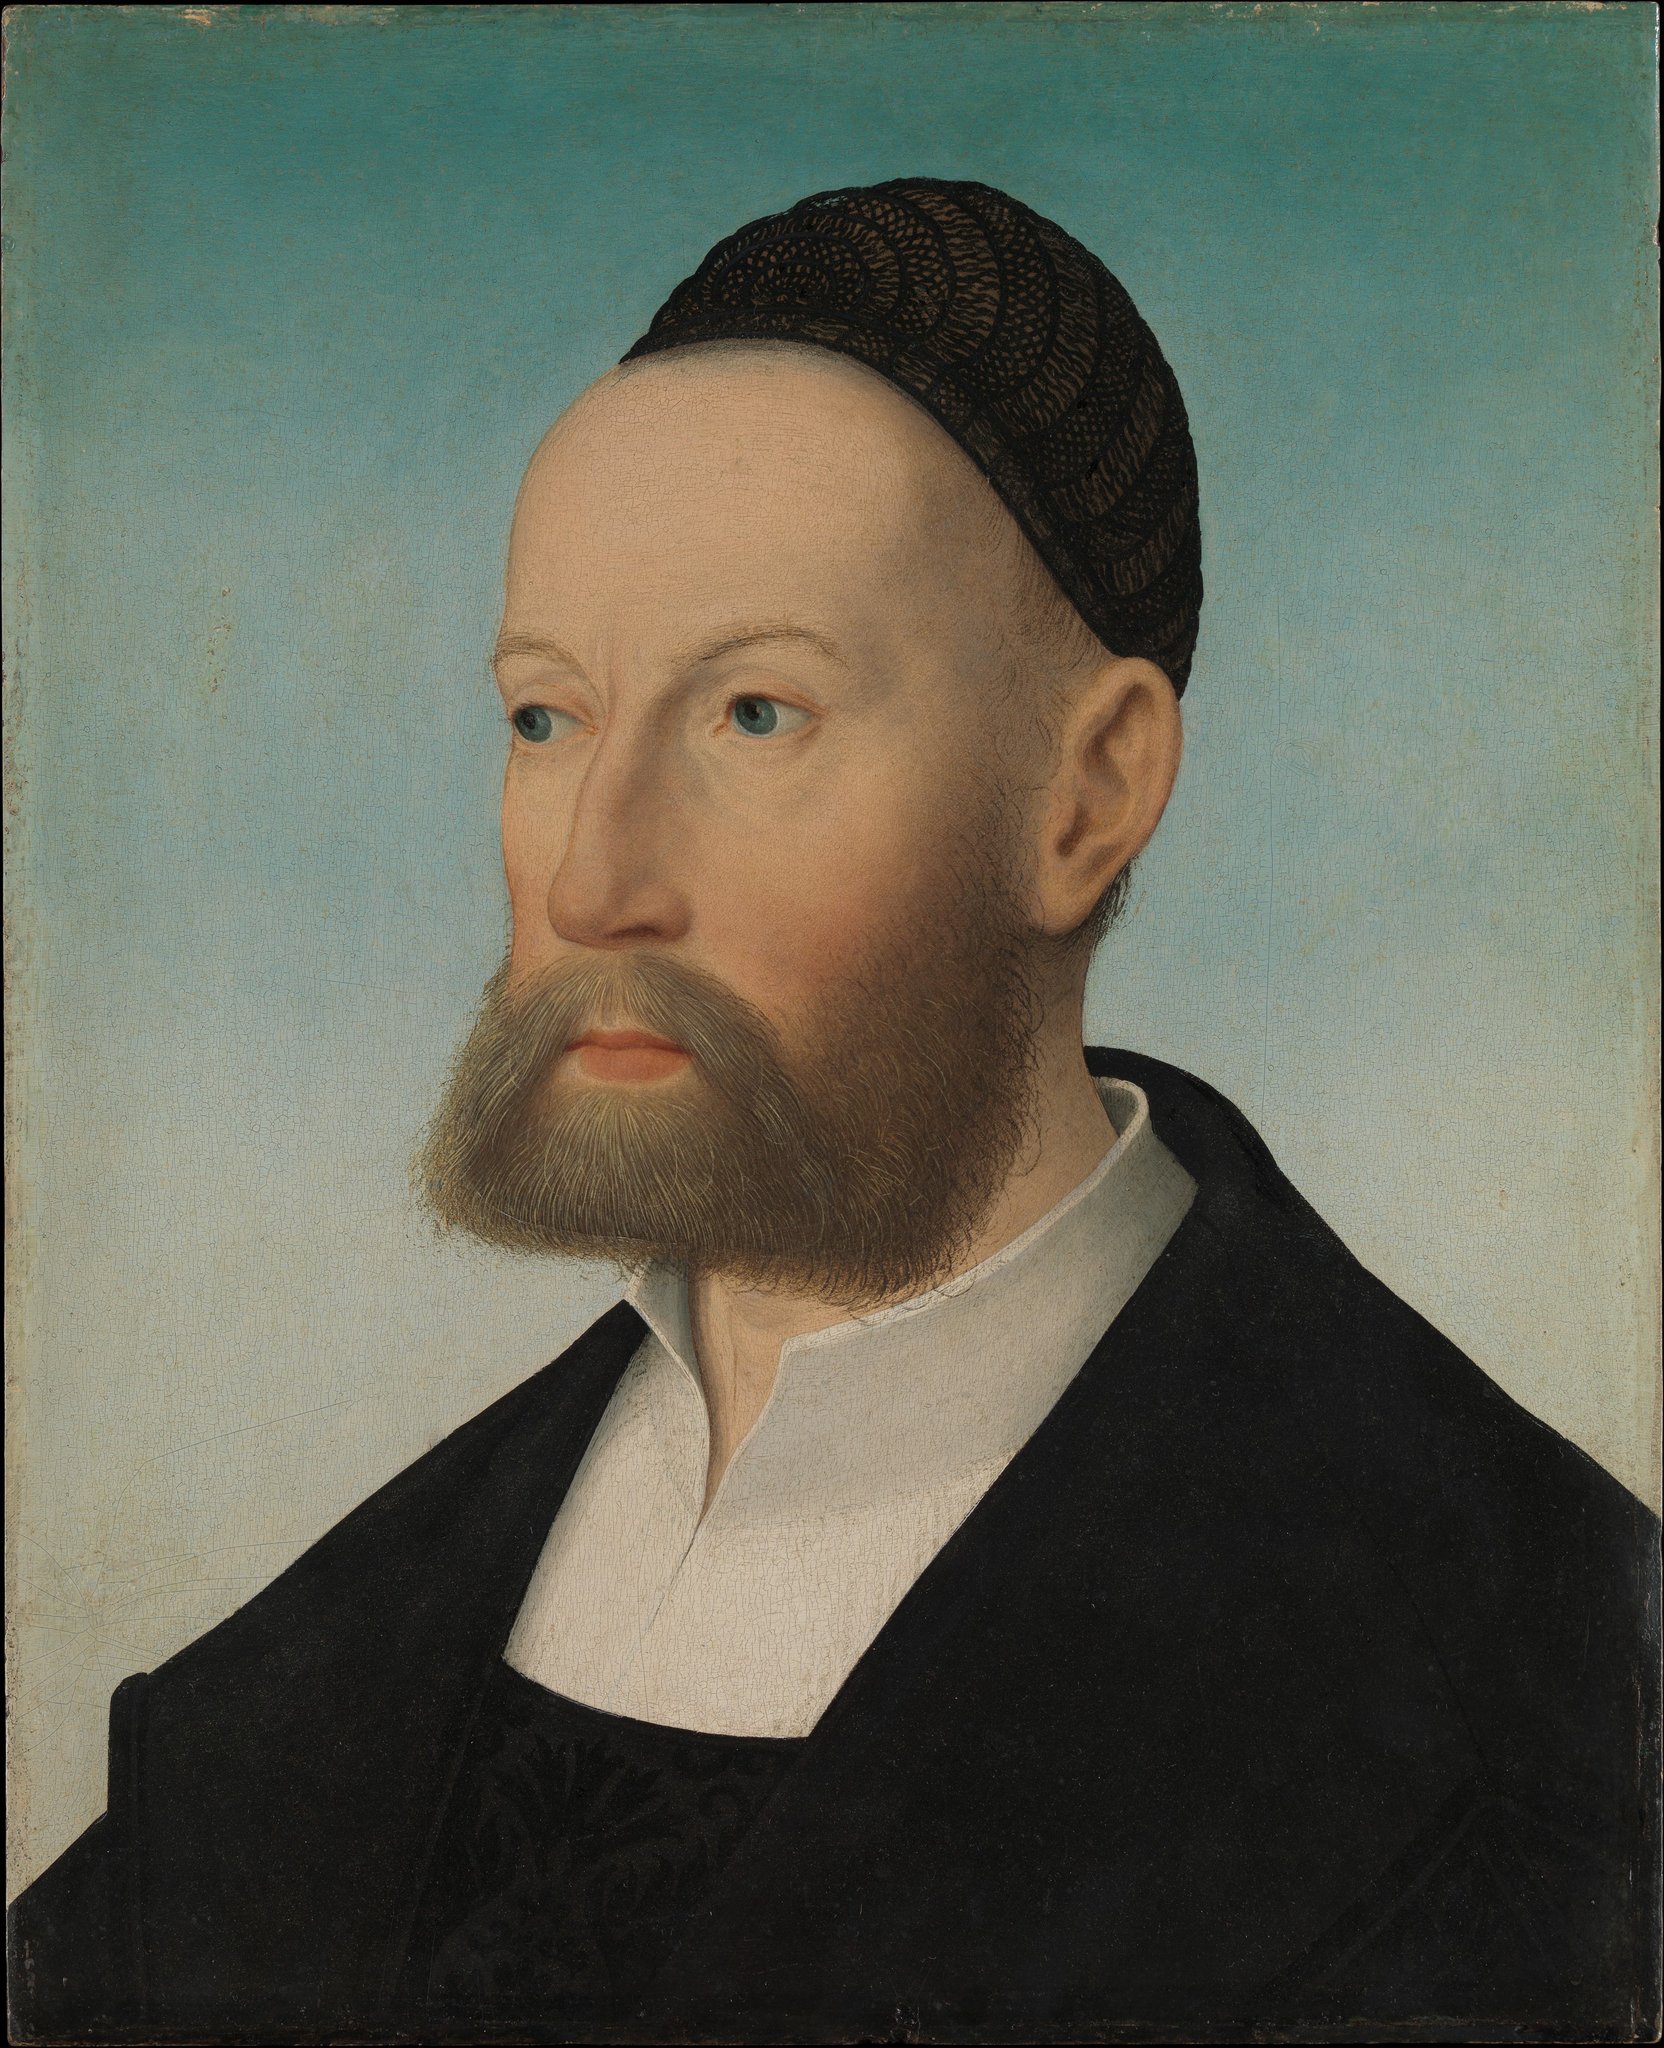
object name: painting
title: Ulrich Fugger the Younger (1490–1525)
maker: hans maler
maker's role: artist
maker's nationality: german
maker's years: 1475-1529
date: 1525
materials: wood, oil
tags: men,portraits